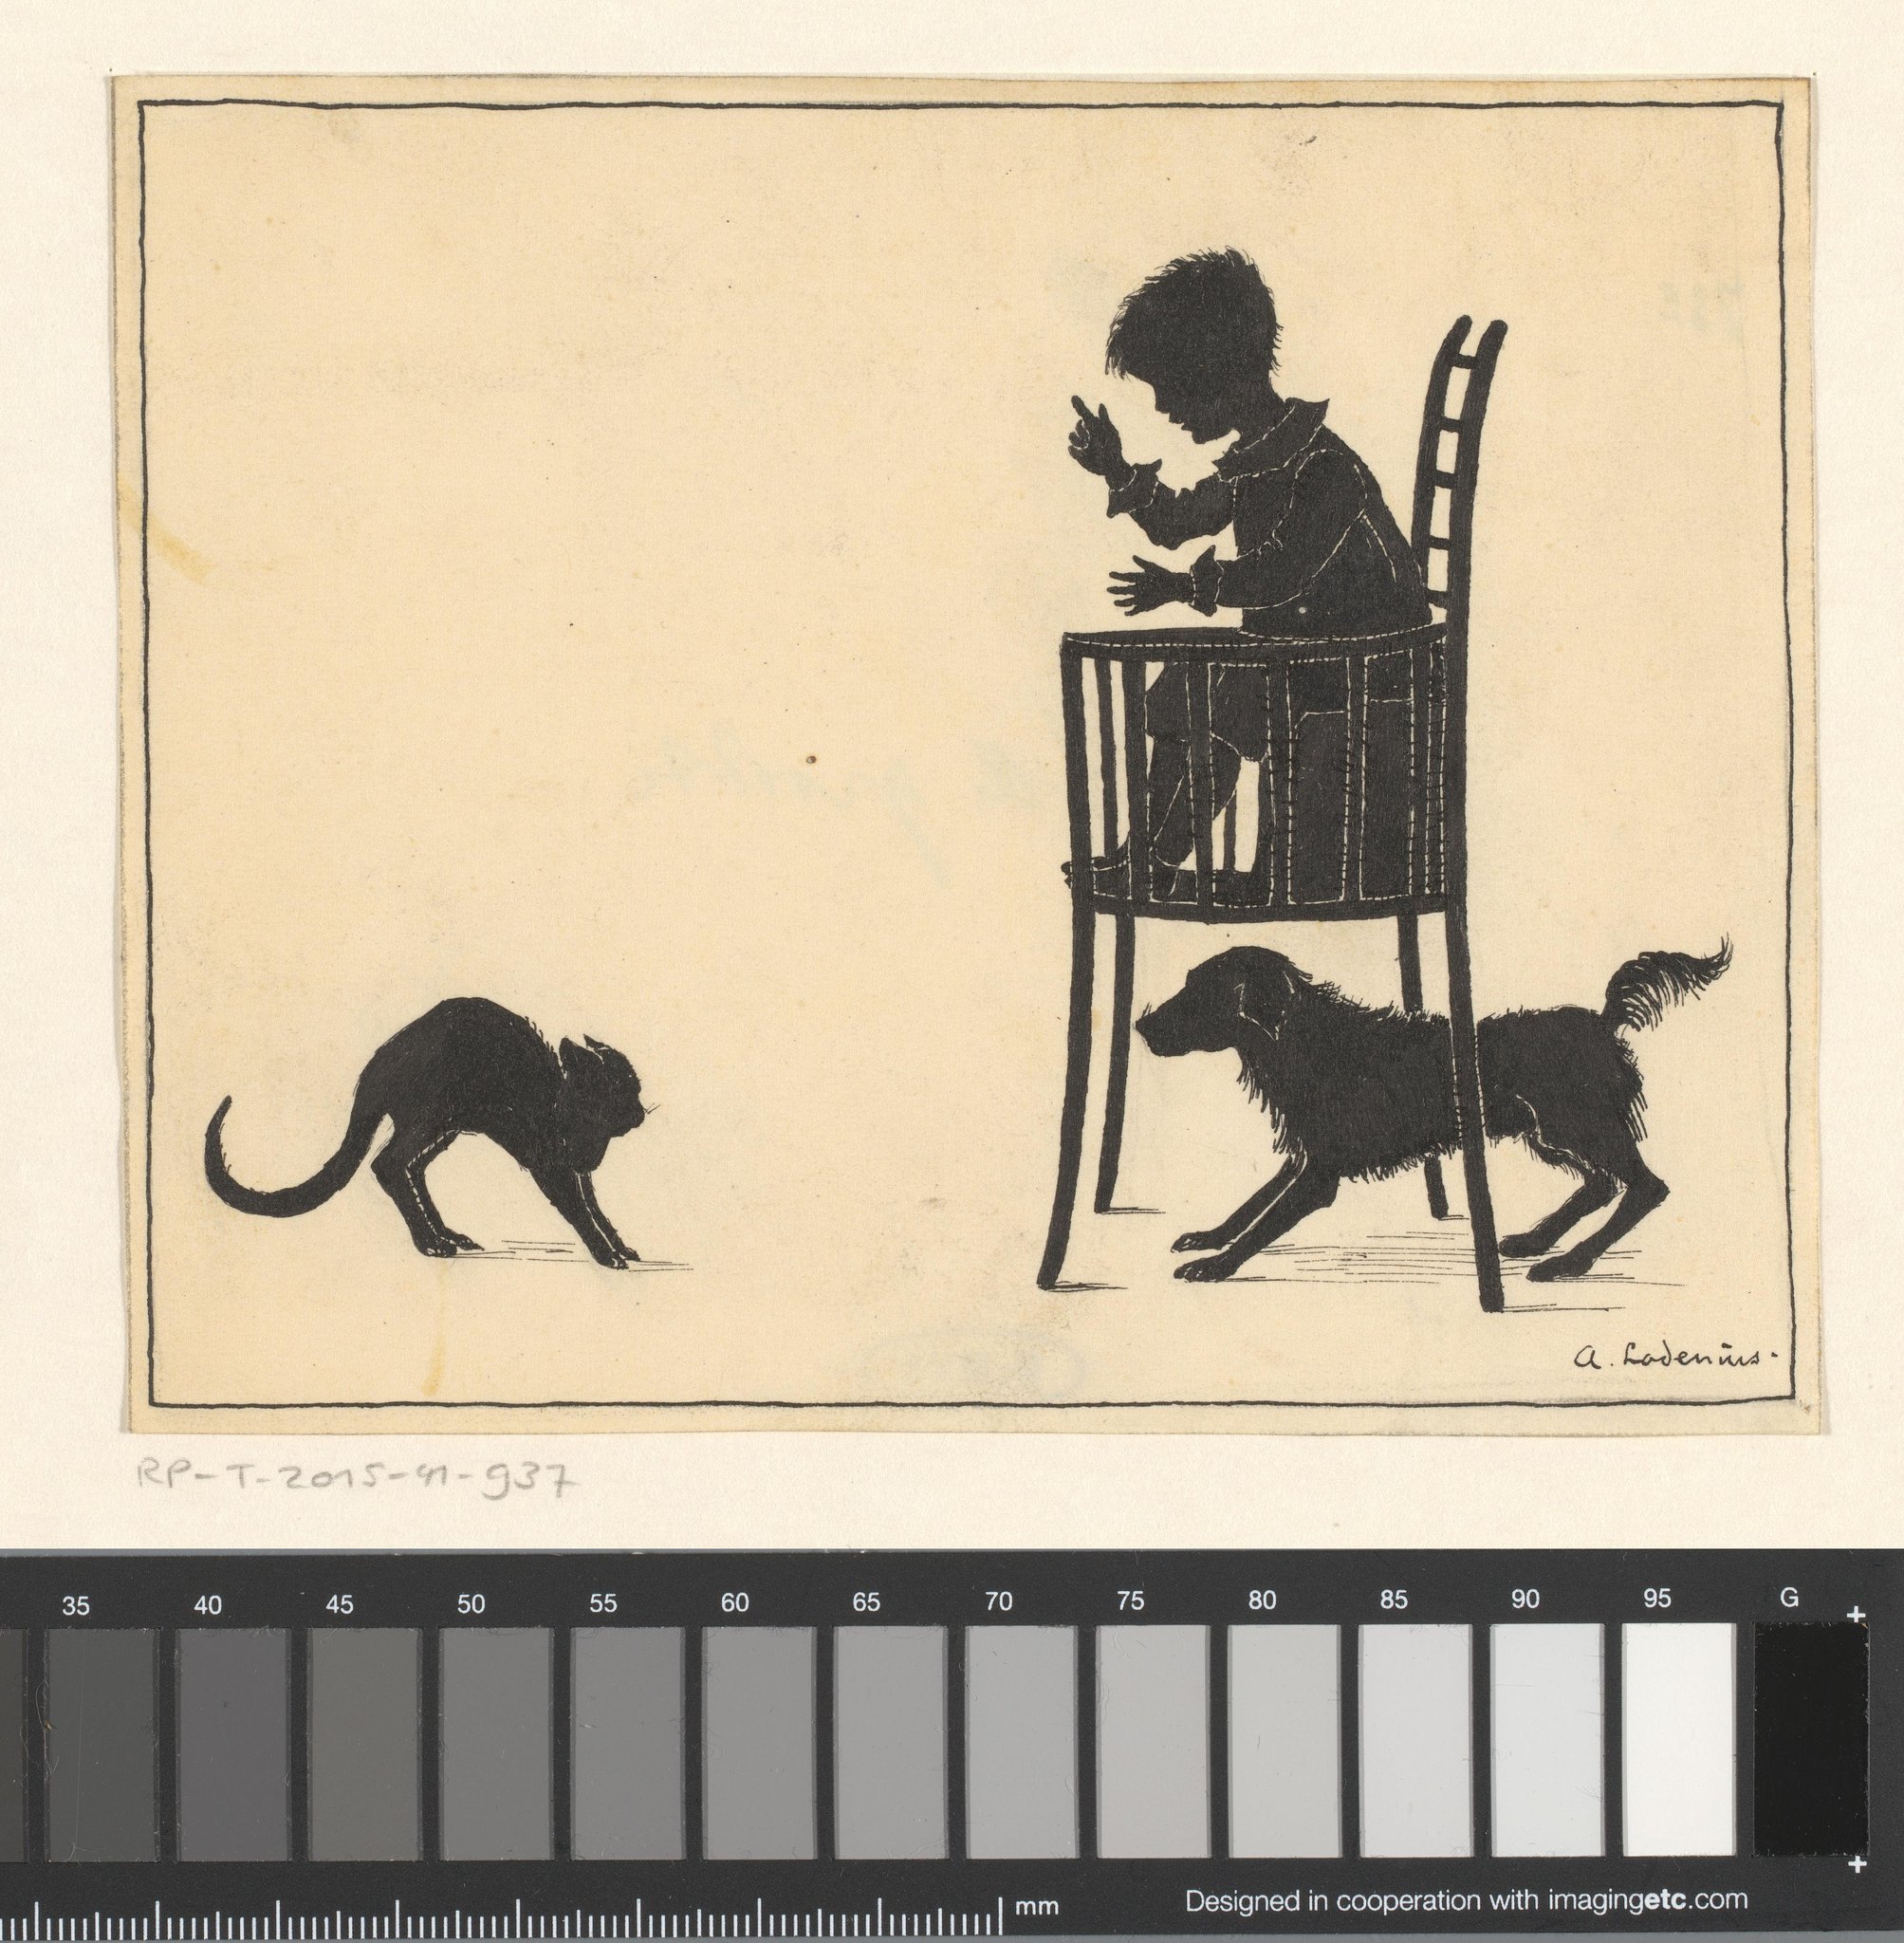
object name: drawing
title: Kat en hond rond een kinderstoel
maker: adri ladenius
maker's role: draughtsman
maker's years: 1883-1953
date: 1893-1953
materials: ink, paper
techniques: pen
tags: cat, boy (child between toddler and youth), table, dog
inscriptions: signature: ‘A. Ladenius.’, collector's mark: Lugt 2228, :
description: Een jongen zit in een kinderstoel en steekt zijn rechter wijsvinger omhoog. Op de grond staan een kat en hond tegenover elkaar. De kat maakt een terugtrekkende beweging.